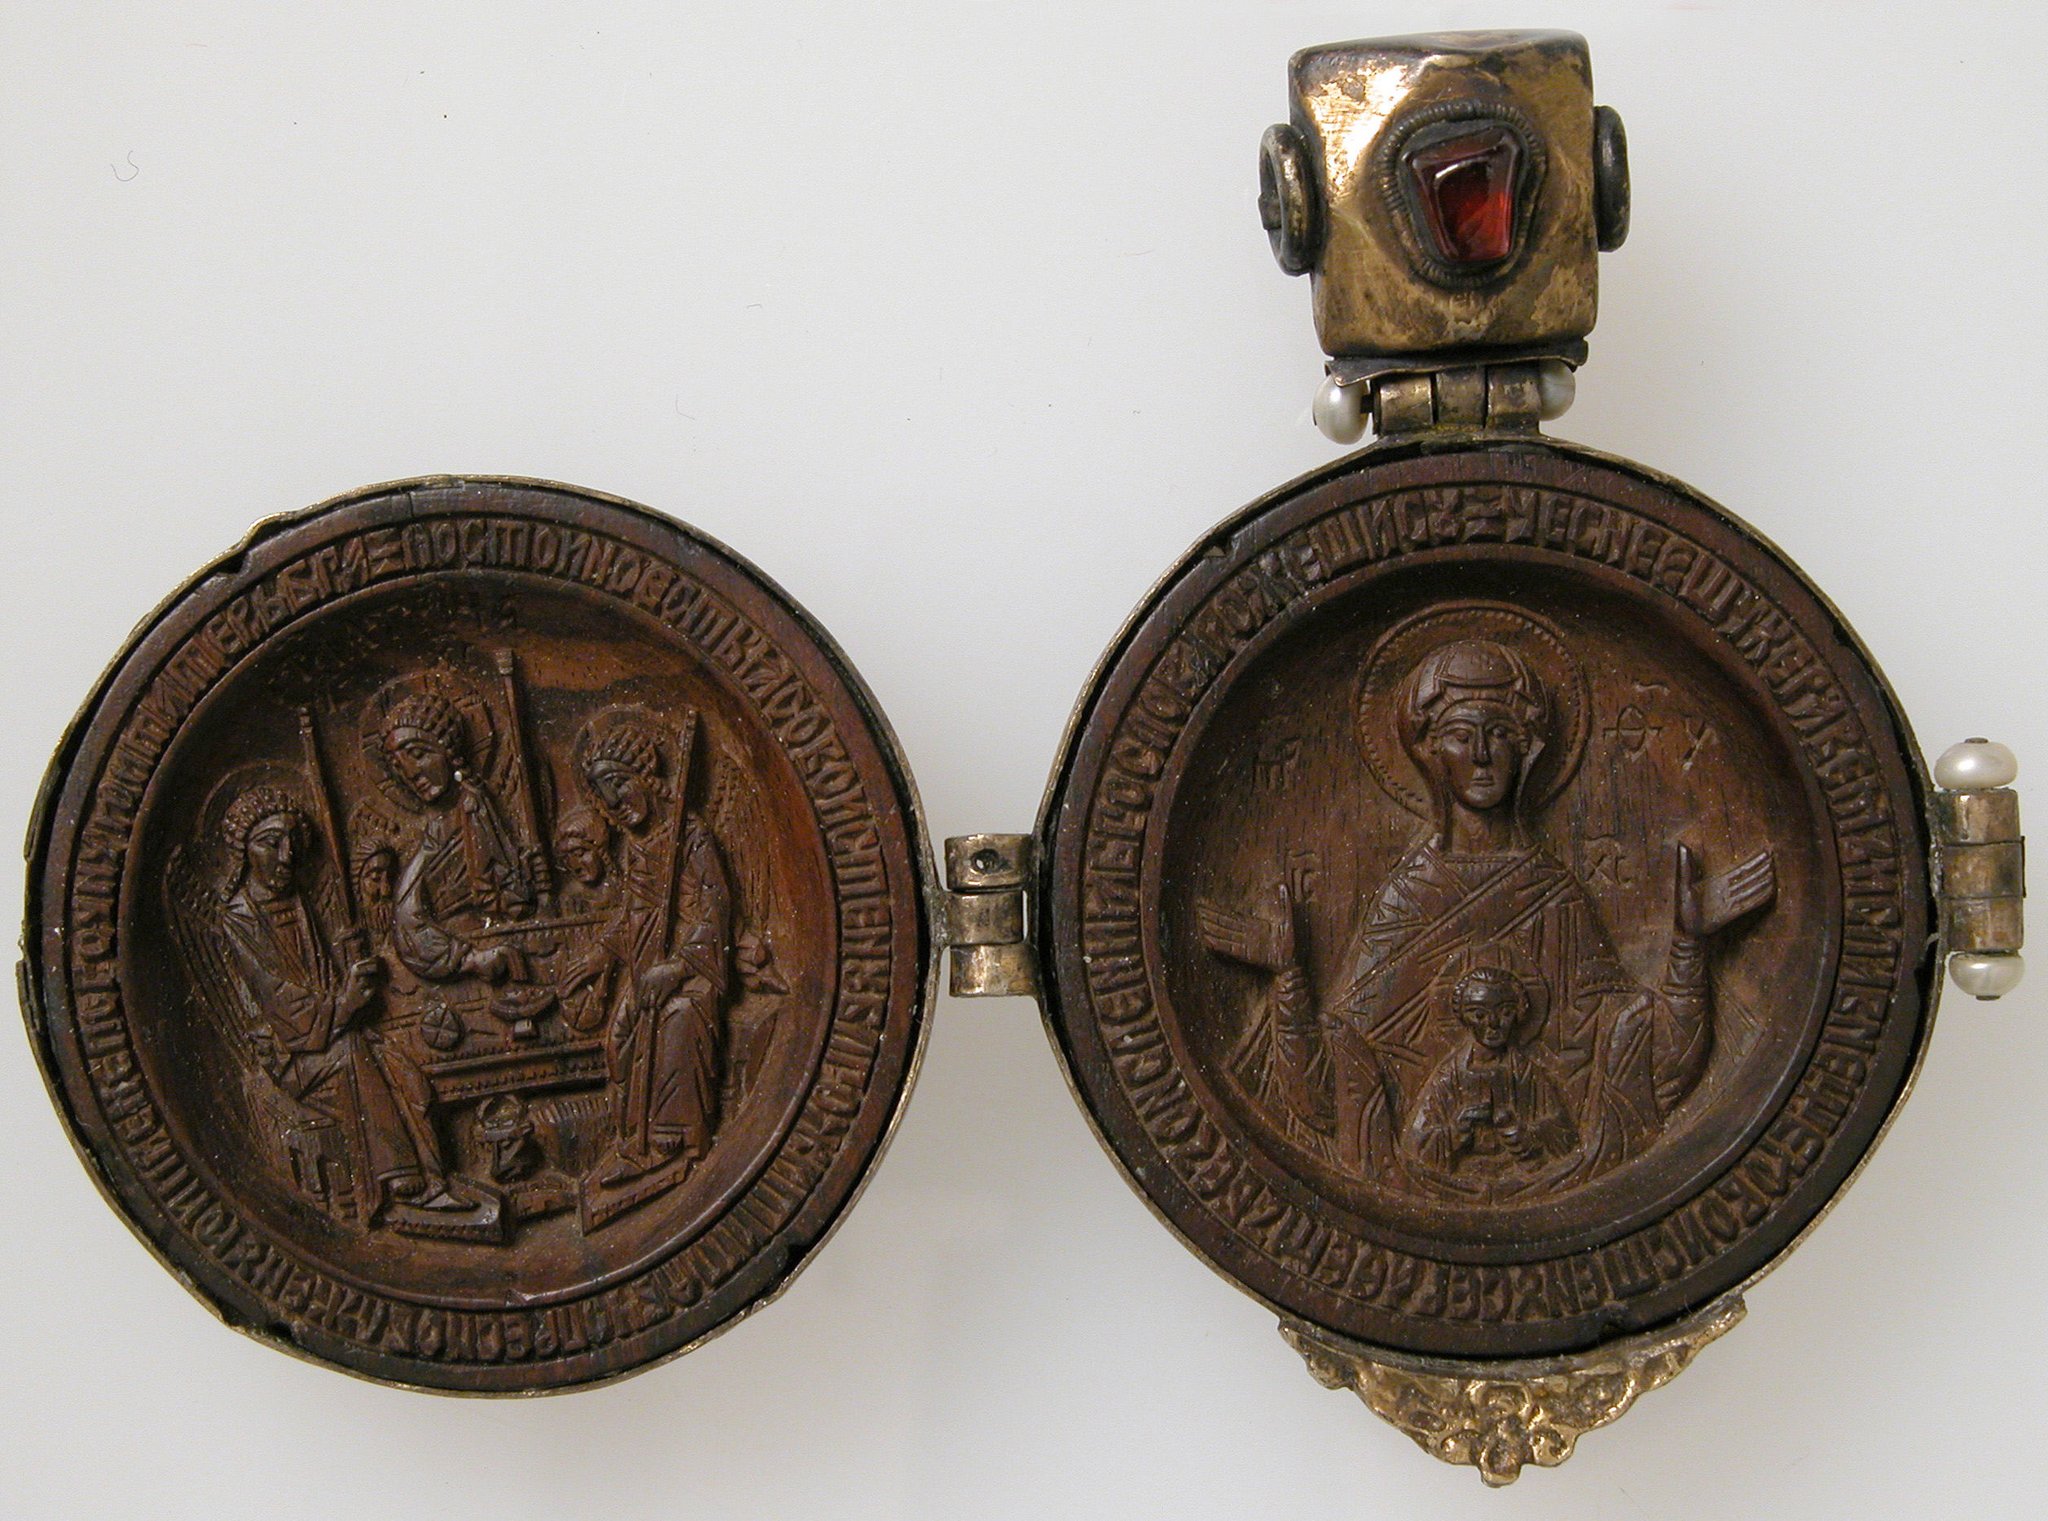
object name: panagiarion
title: Panagiarion with the Virgin and Child and the Three Angels at Mamre (interior) and the Crucifixion and Three Church Fathers (exterior)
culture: russian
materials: gemstone, pearl, silver gilt, wood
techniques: stain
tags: angels,crucifixion